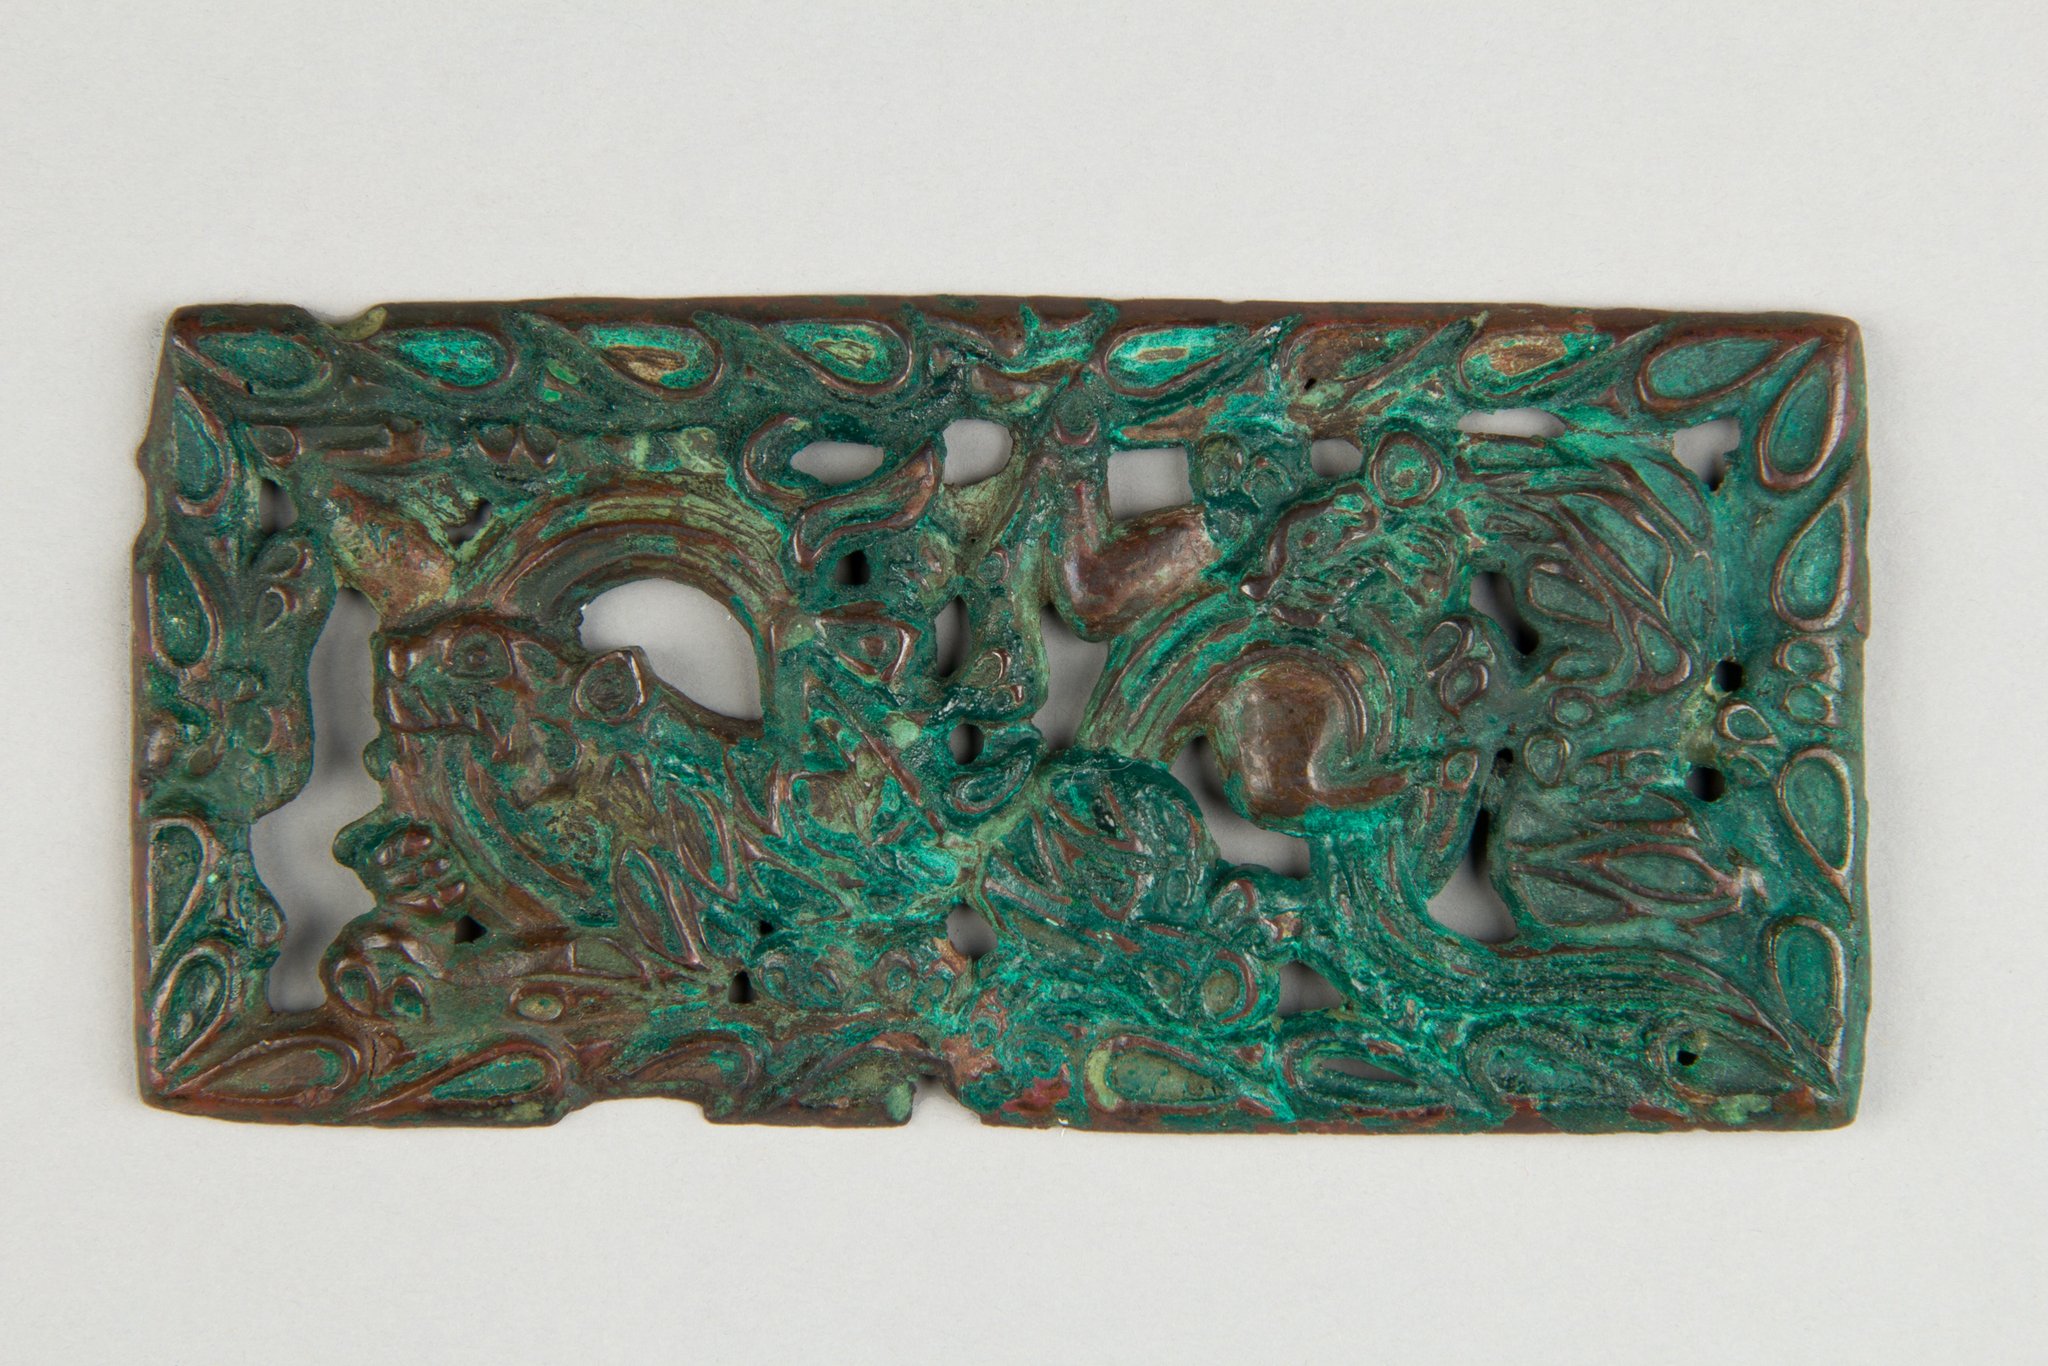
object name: belt plaque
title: Belt Plaque with Tigers and Dragon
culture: mongolia or siberia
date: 200-101 BCE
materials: bronze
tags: dragons,tigers